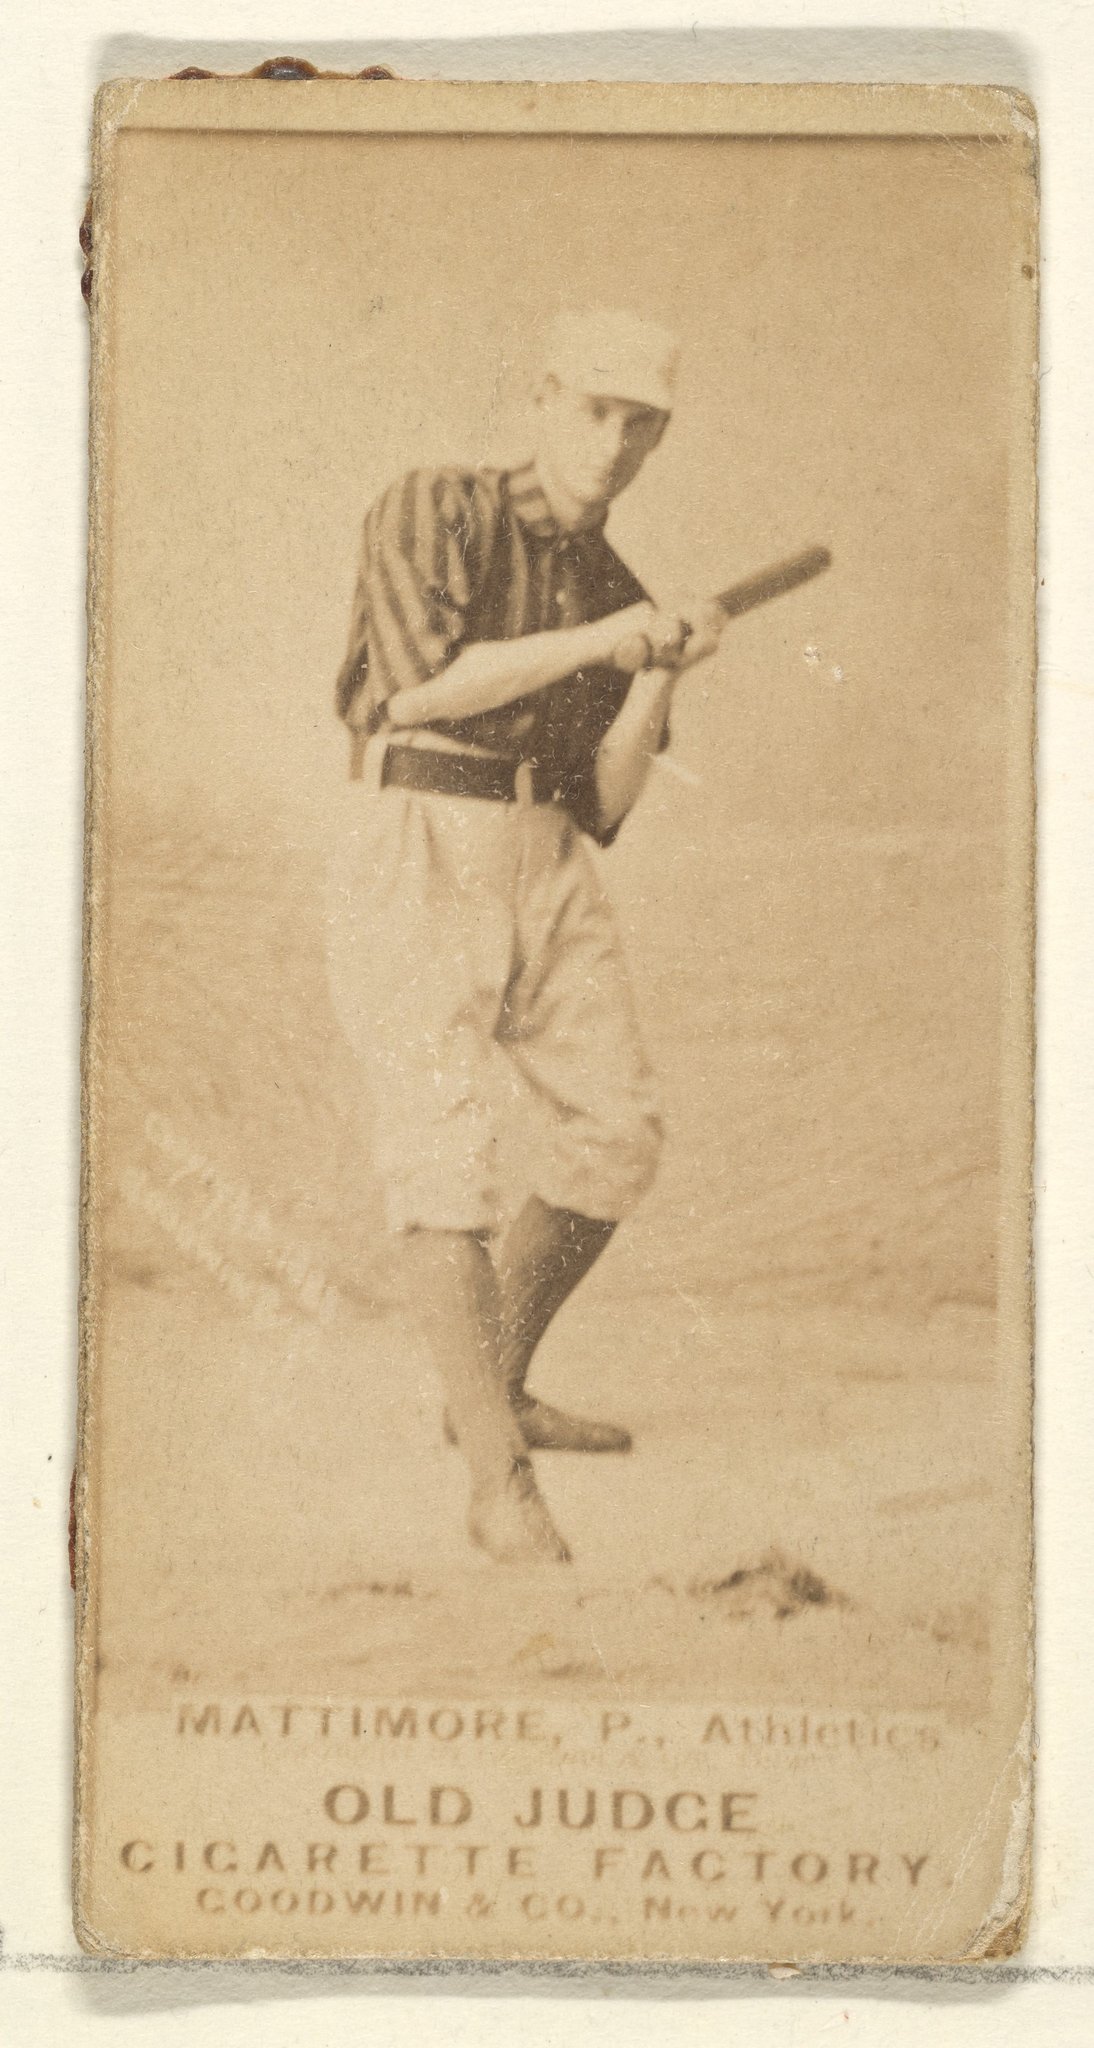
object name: baseball card, photograph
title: Mattimore, Pitcher, Philadelphia Athletics, from the Old Judge series (N172) for Old Judge Cigarettes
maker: goodwin & company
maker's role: publisher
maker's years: 1850-1950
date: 1888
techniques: albumen silver print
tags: men,portraits,baseball,athletes